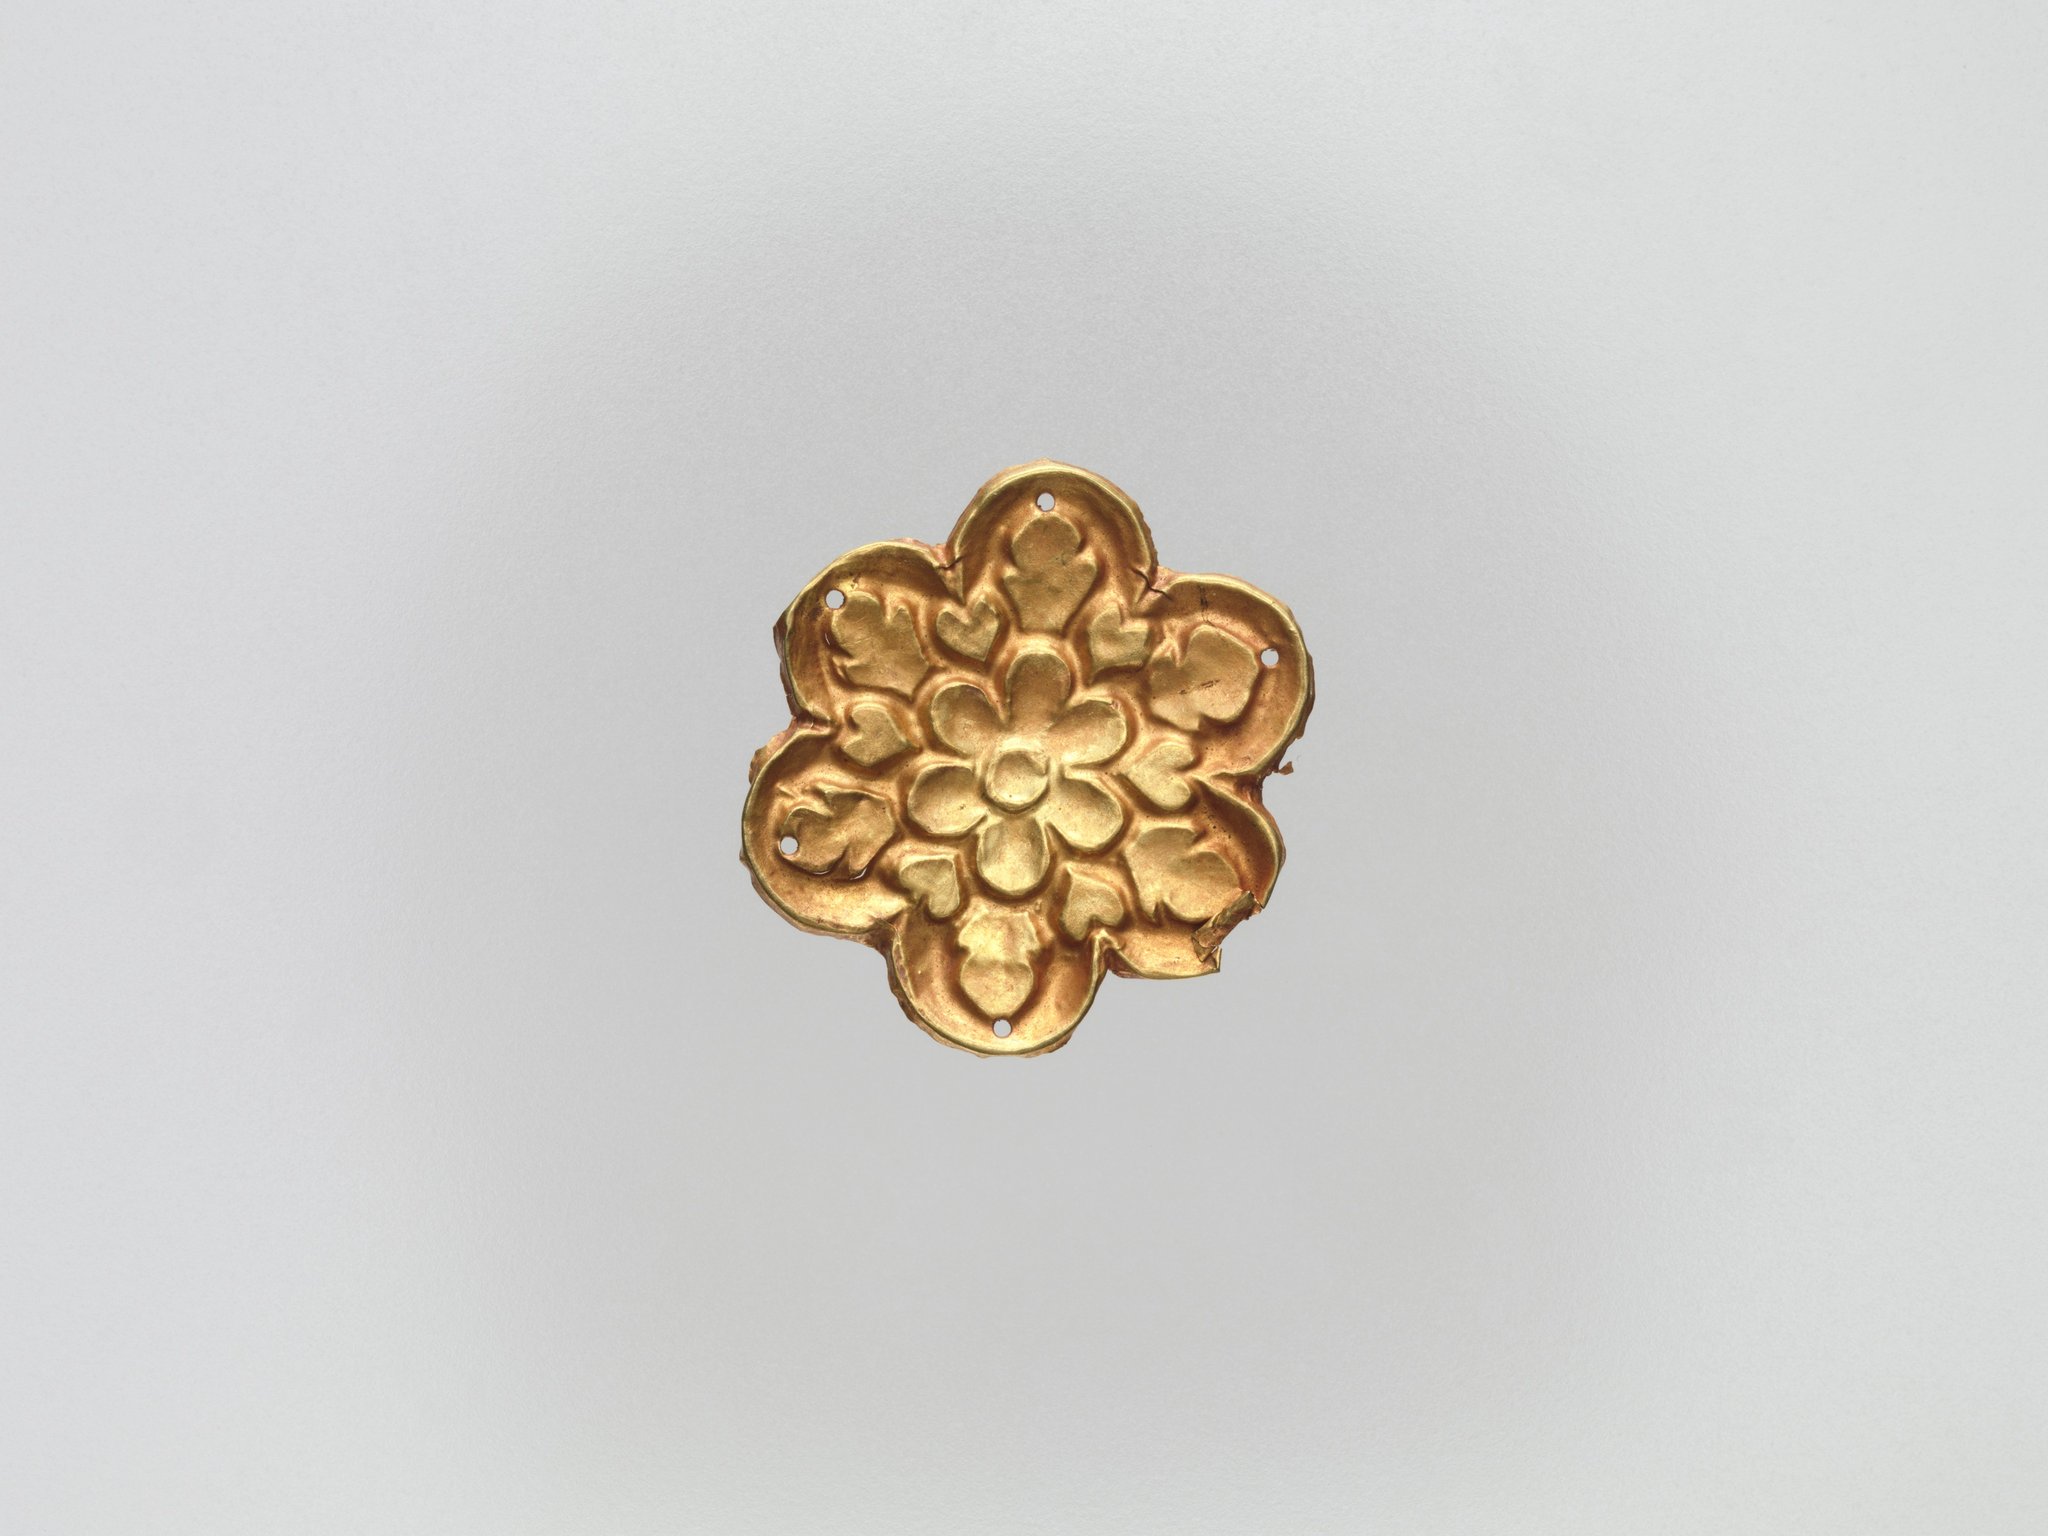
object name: garment plaque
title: Flower-Shaped Clothing Plaque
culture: chinese or central asian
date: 601-900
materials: gold